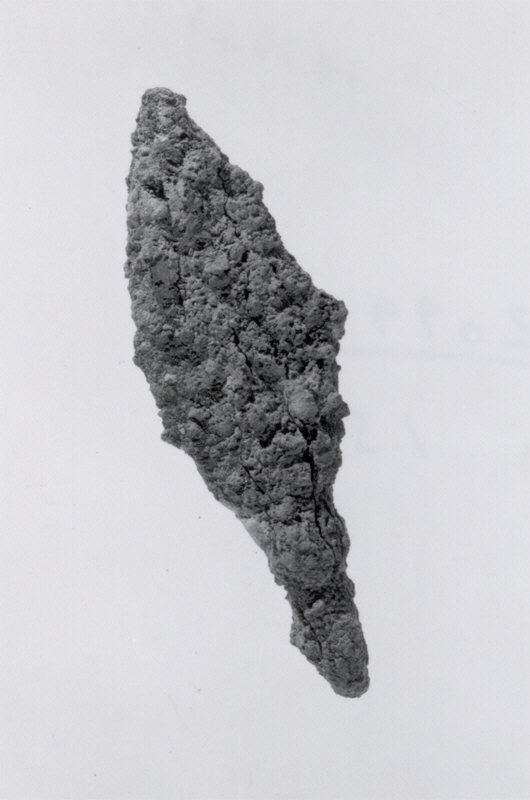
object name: arrowhead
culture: iranian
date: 900-801 BCE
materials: iron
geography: iran